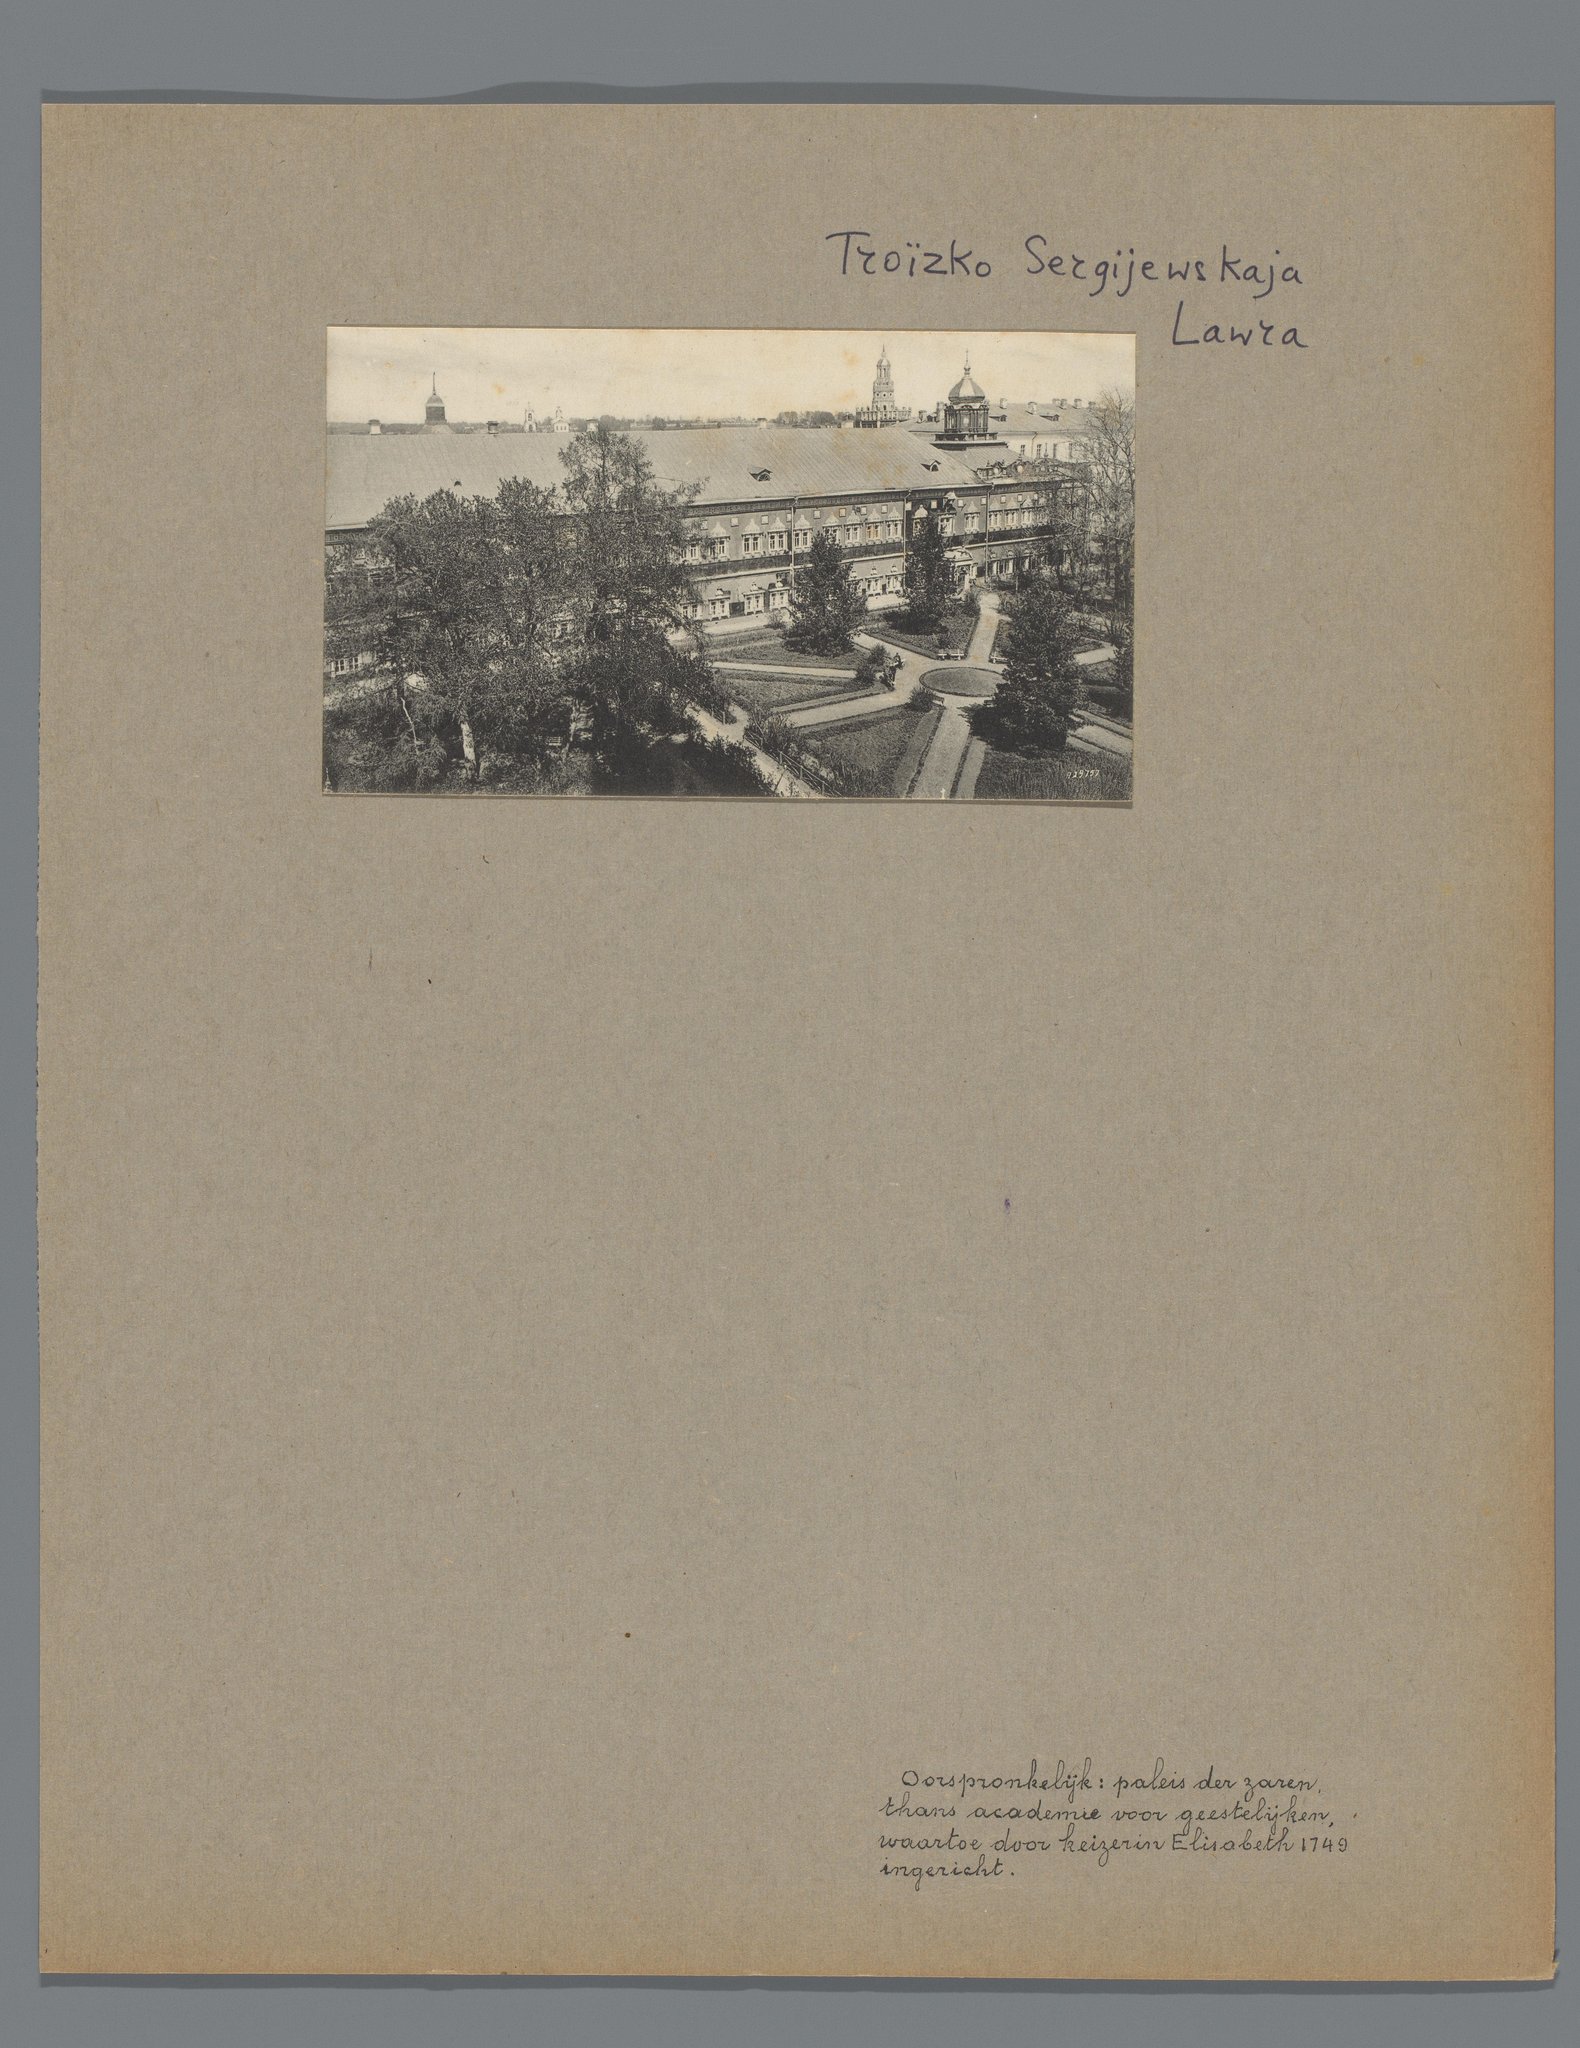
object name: photograph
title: Troïska Sergijewskaja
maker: Anonymous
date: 1860-1925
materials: photographic support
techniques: photograph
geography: russia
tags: russia